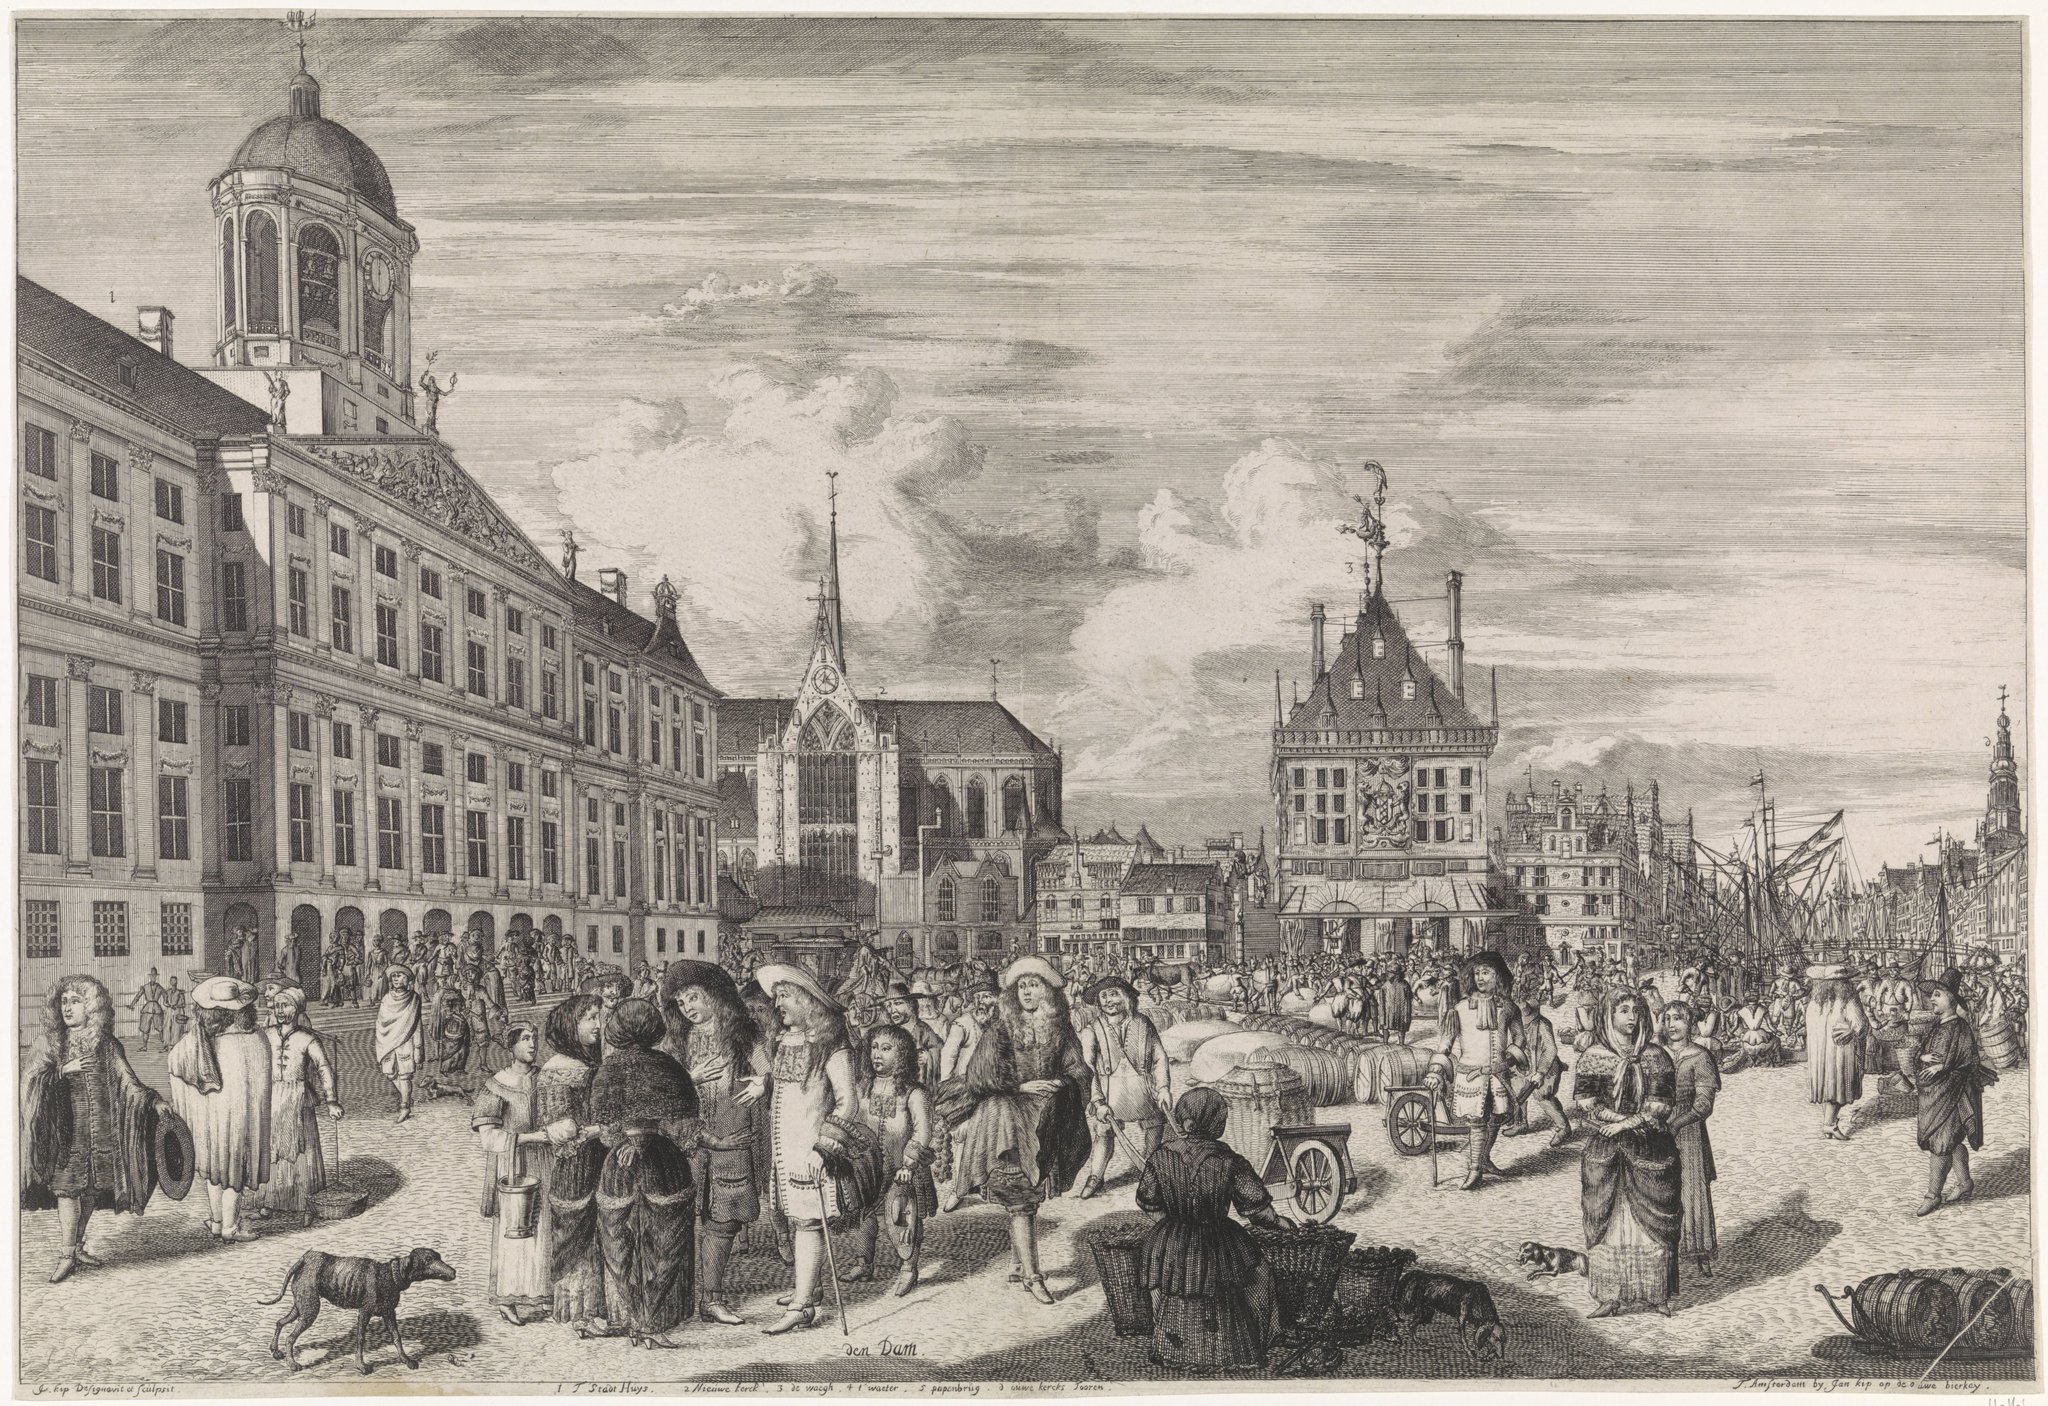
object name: print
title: Dam in Amsterdam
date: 1685-1690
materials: paper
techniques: etching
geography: amsterdam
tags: head-gear: hat (+ men's clothes), clothes, costume (+ women's clothes), clothes, costume (+ men's clothes), dog, amsterdam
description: Kleding: